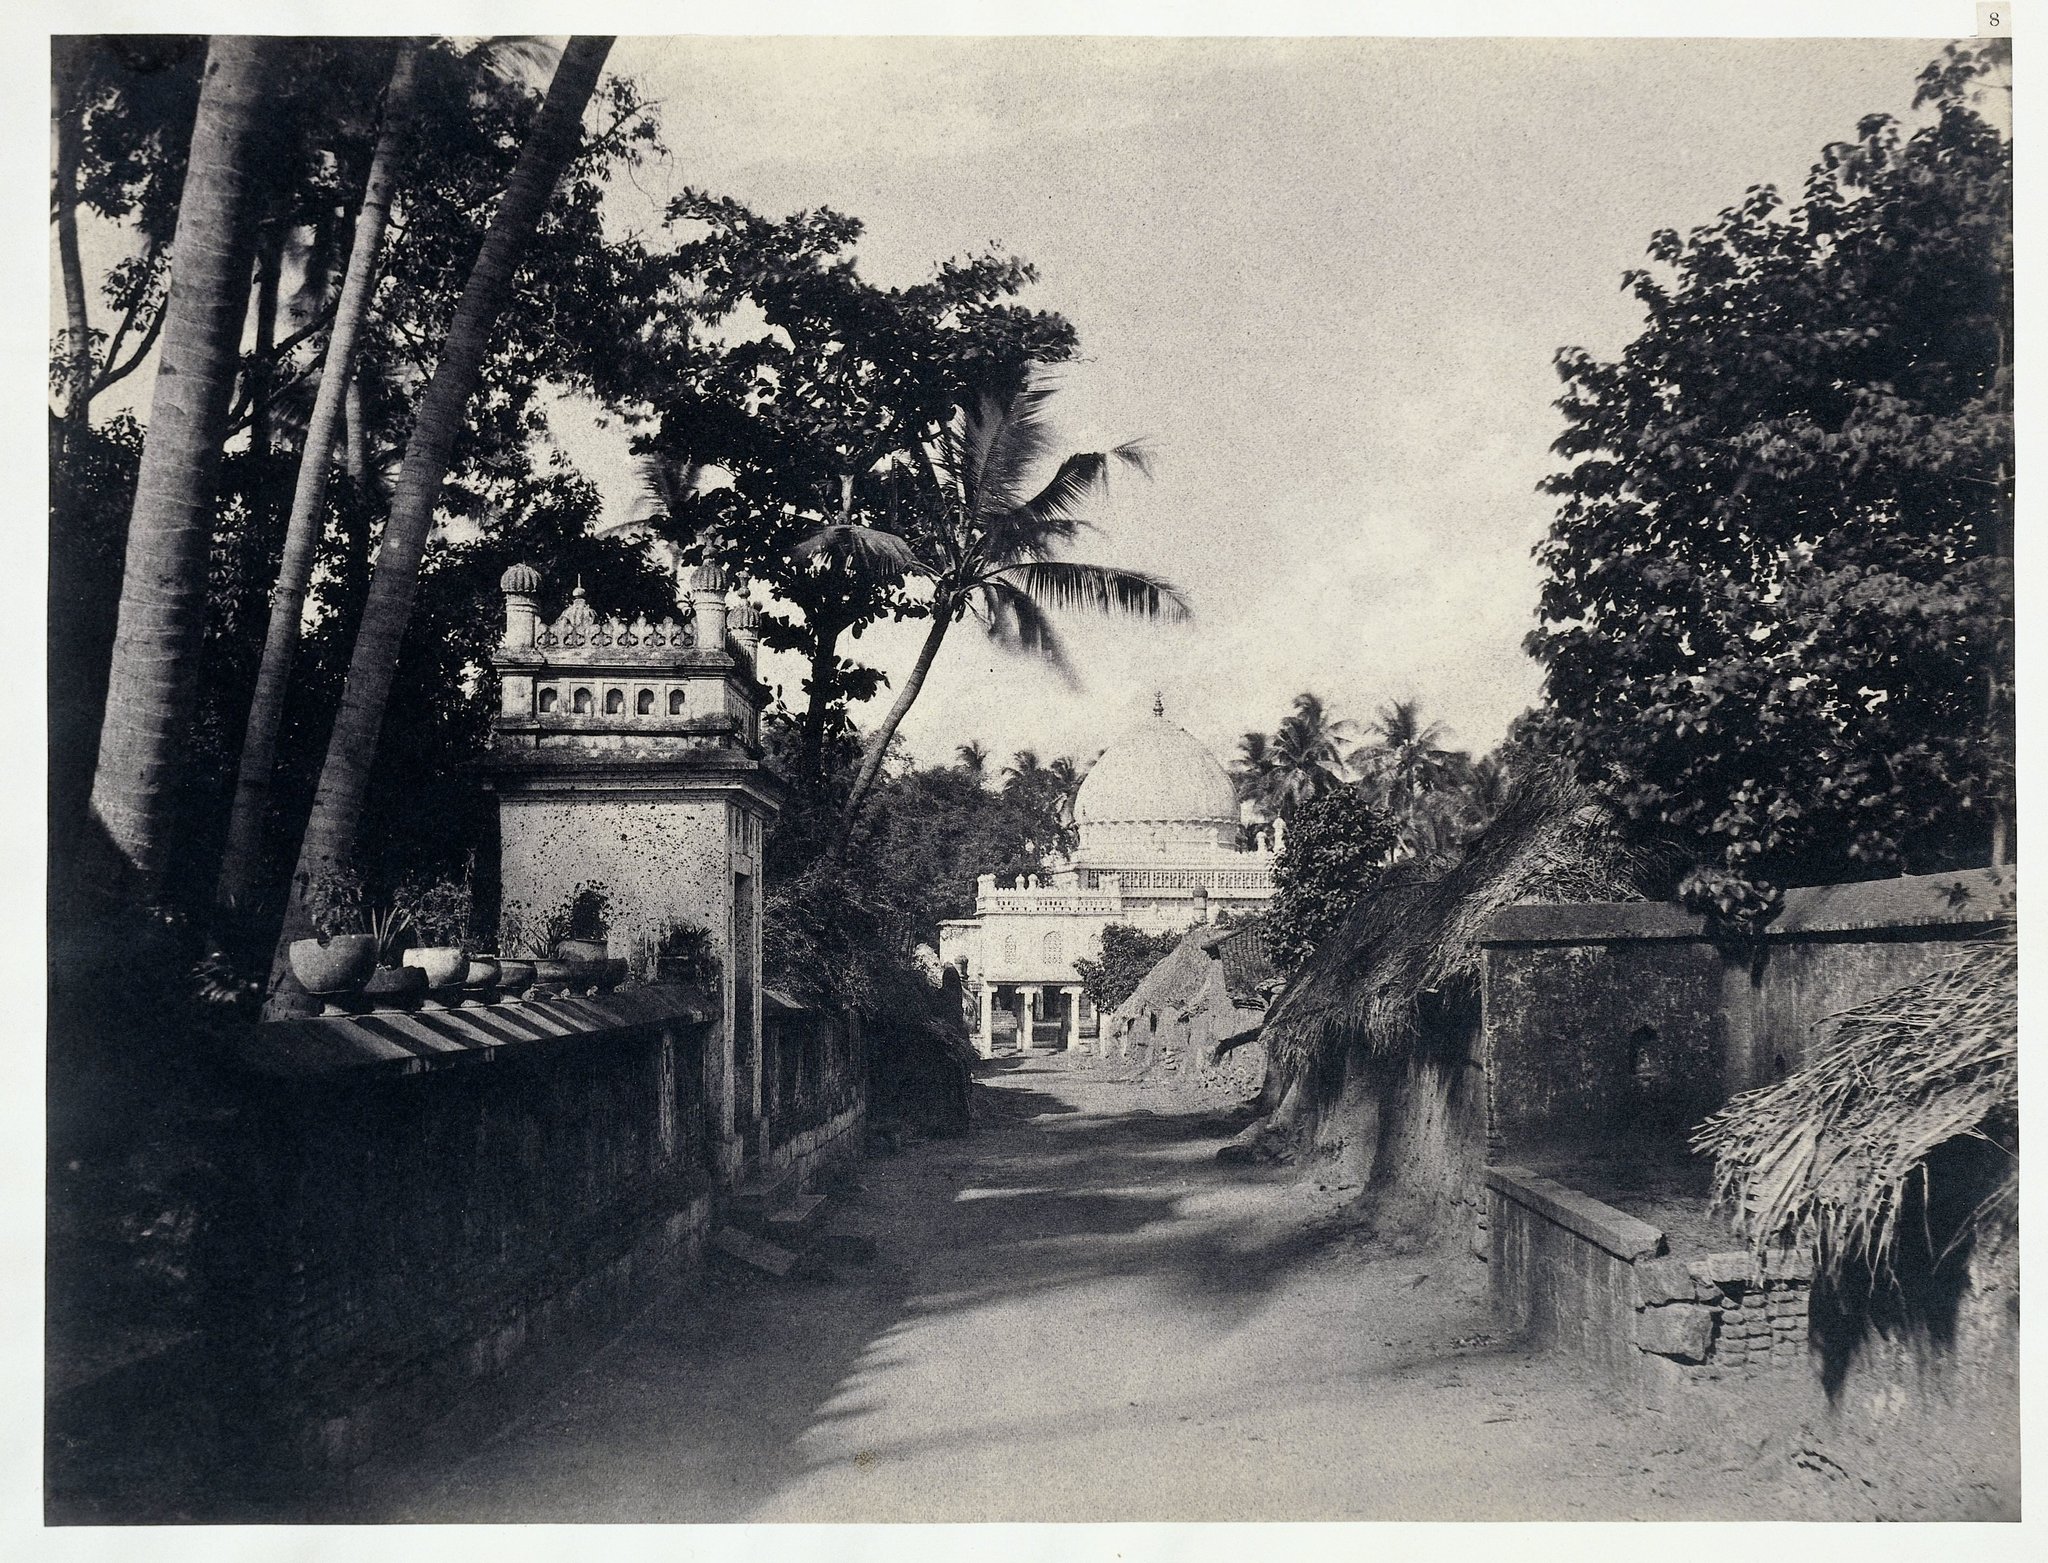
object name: photograph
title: View of the Mosque of Nutter Owleah, Tiruchirappalli, India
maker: linnaeus tripe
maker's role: fotograaf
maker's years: 1822-1902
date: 1858-1860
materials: cardboard, photographic support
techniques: salted paper print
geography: tiruchirappalli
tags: tiruchirapalli, trichinopoly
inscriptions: number: ‘8’, monogram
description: Tripe used paper rather than glass negatives. Not only were they unbreakable and easy to take along, but the light sensitive layer was also more resistant to the fierce heat and humidity in India and Burma. He took close to 1000 photographs as an officer in the British army. Tripe provided his printing papers with a thin layer of albumen, making them glossier than regular salted paper prints.